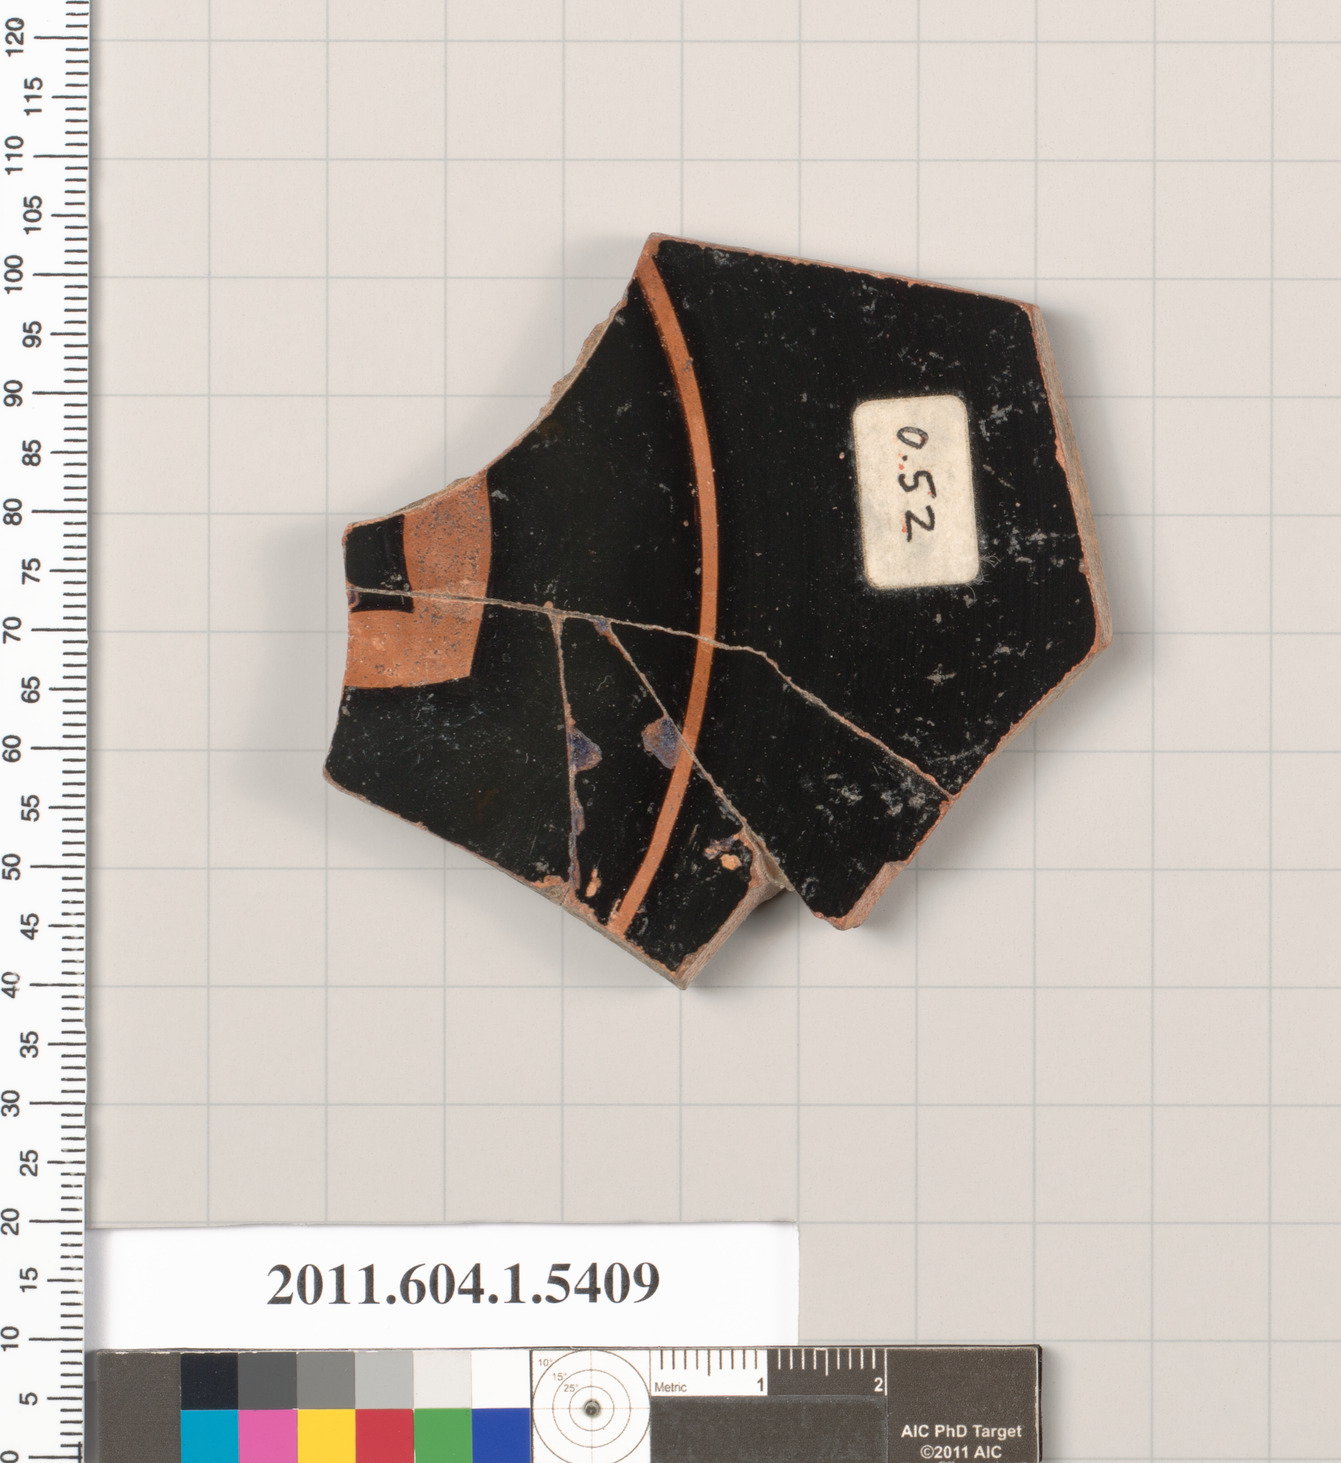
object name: kylix fragment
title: Terracotta fragment of a kylix (drinking cup)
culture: greek, attic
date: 510-490 BCE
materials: terracotta